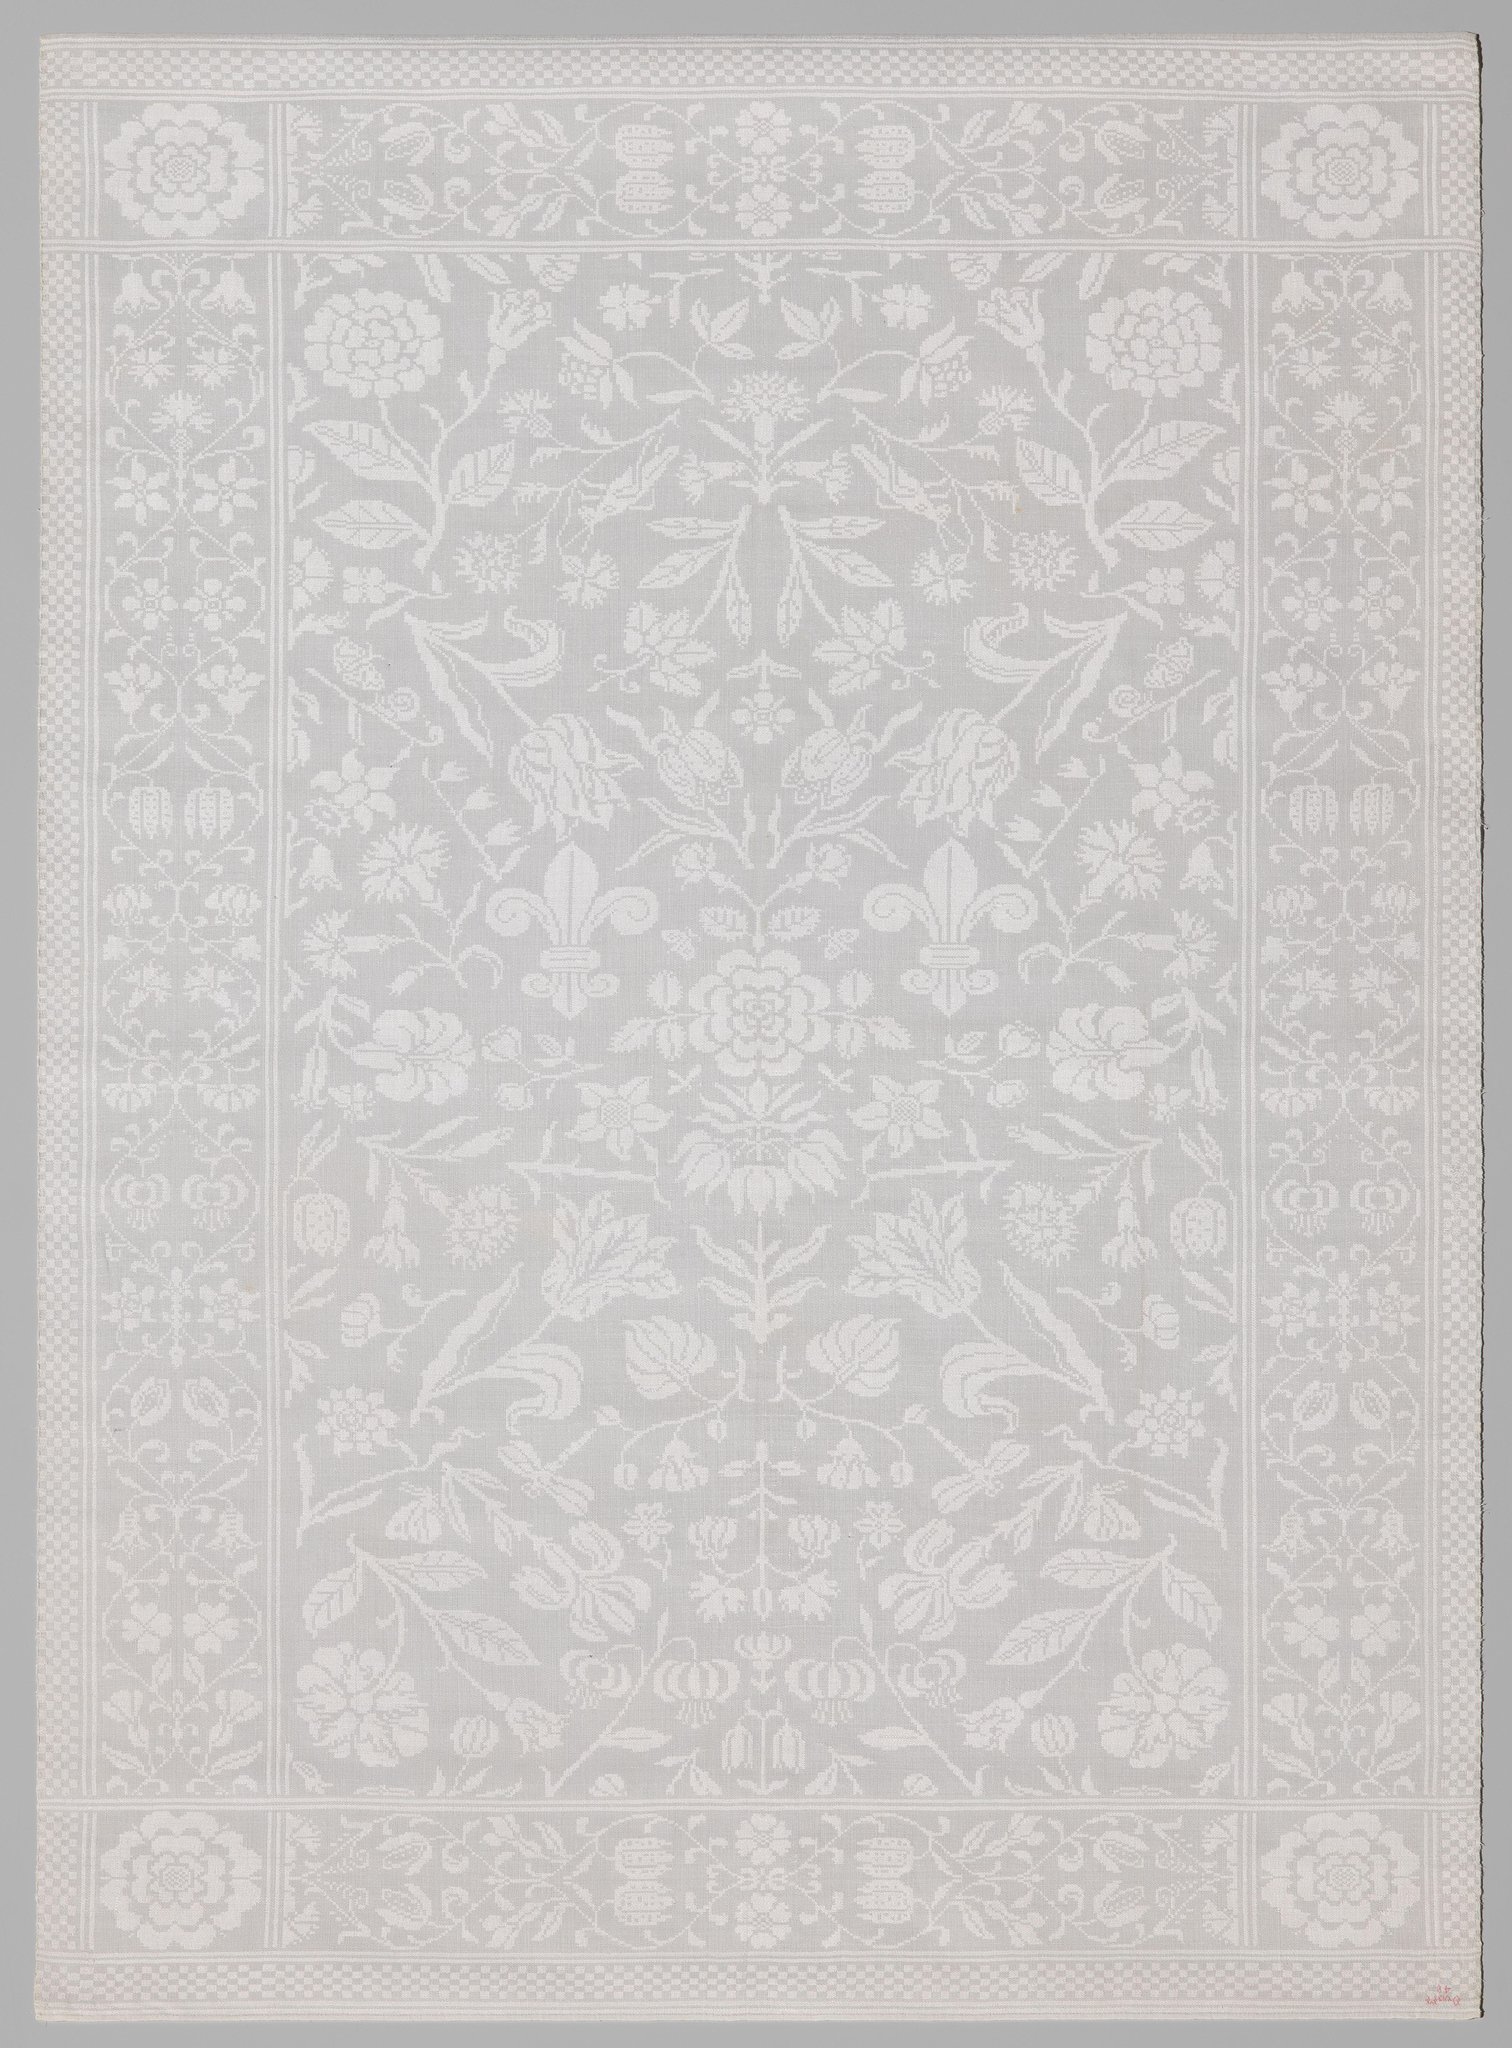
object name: napkin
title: Servet van wit linnendamast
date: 1640-1660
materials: linen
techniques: damask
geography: northern netherlands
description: Witlinnen damasten servet met een patroon van gestrooide bloemen en een fleur de lis, gemerkt DvdM 40.